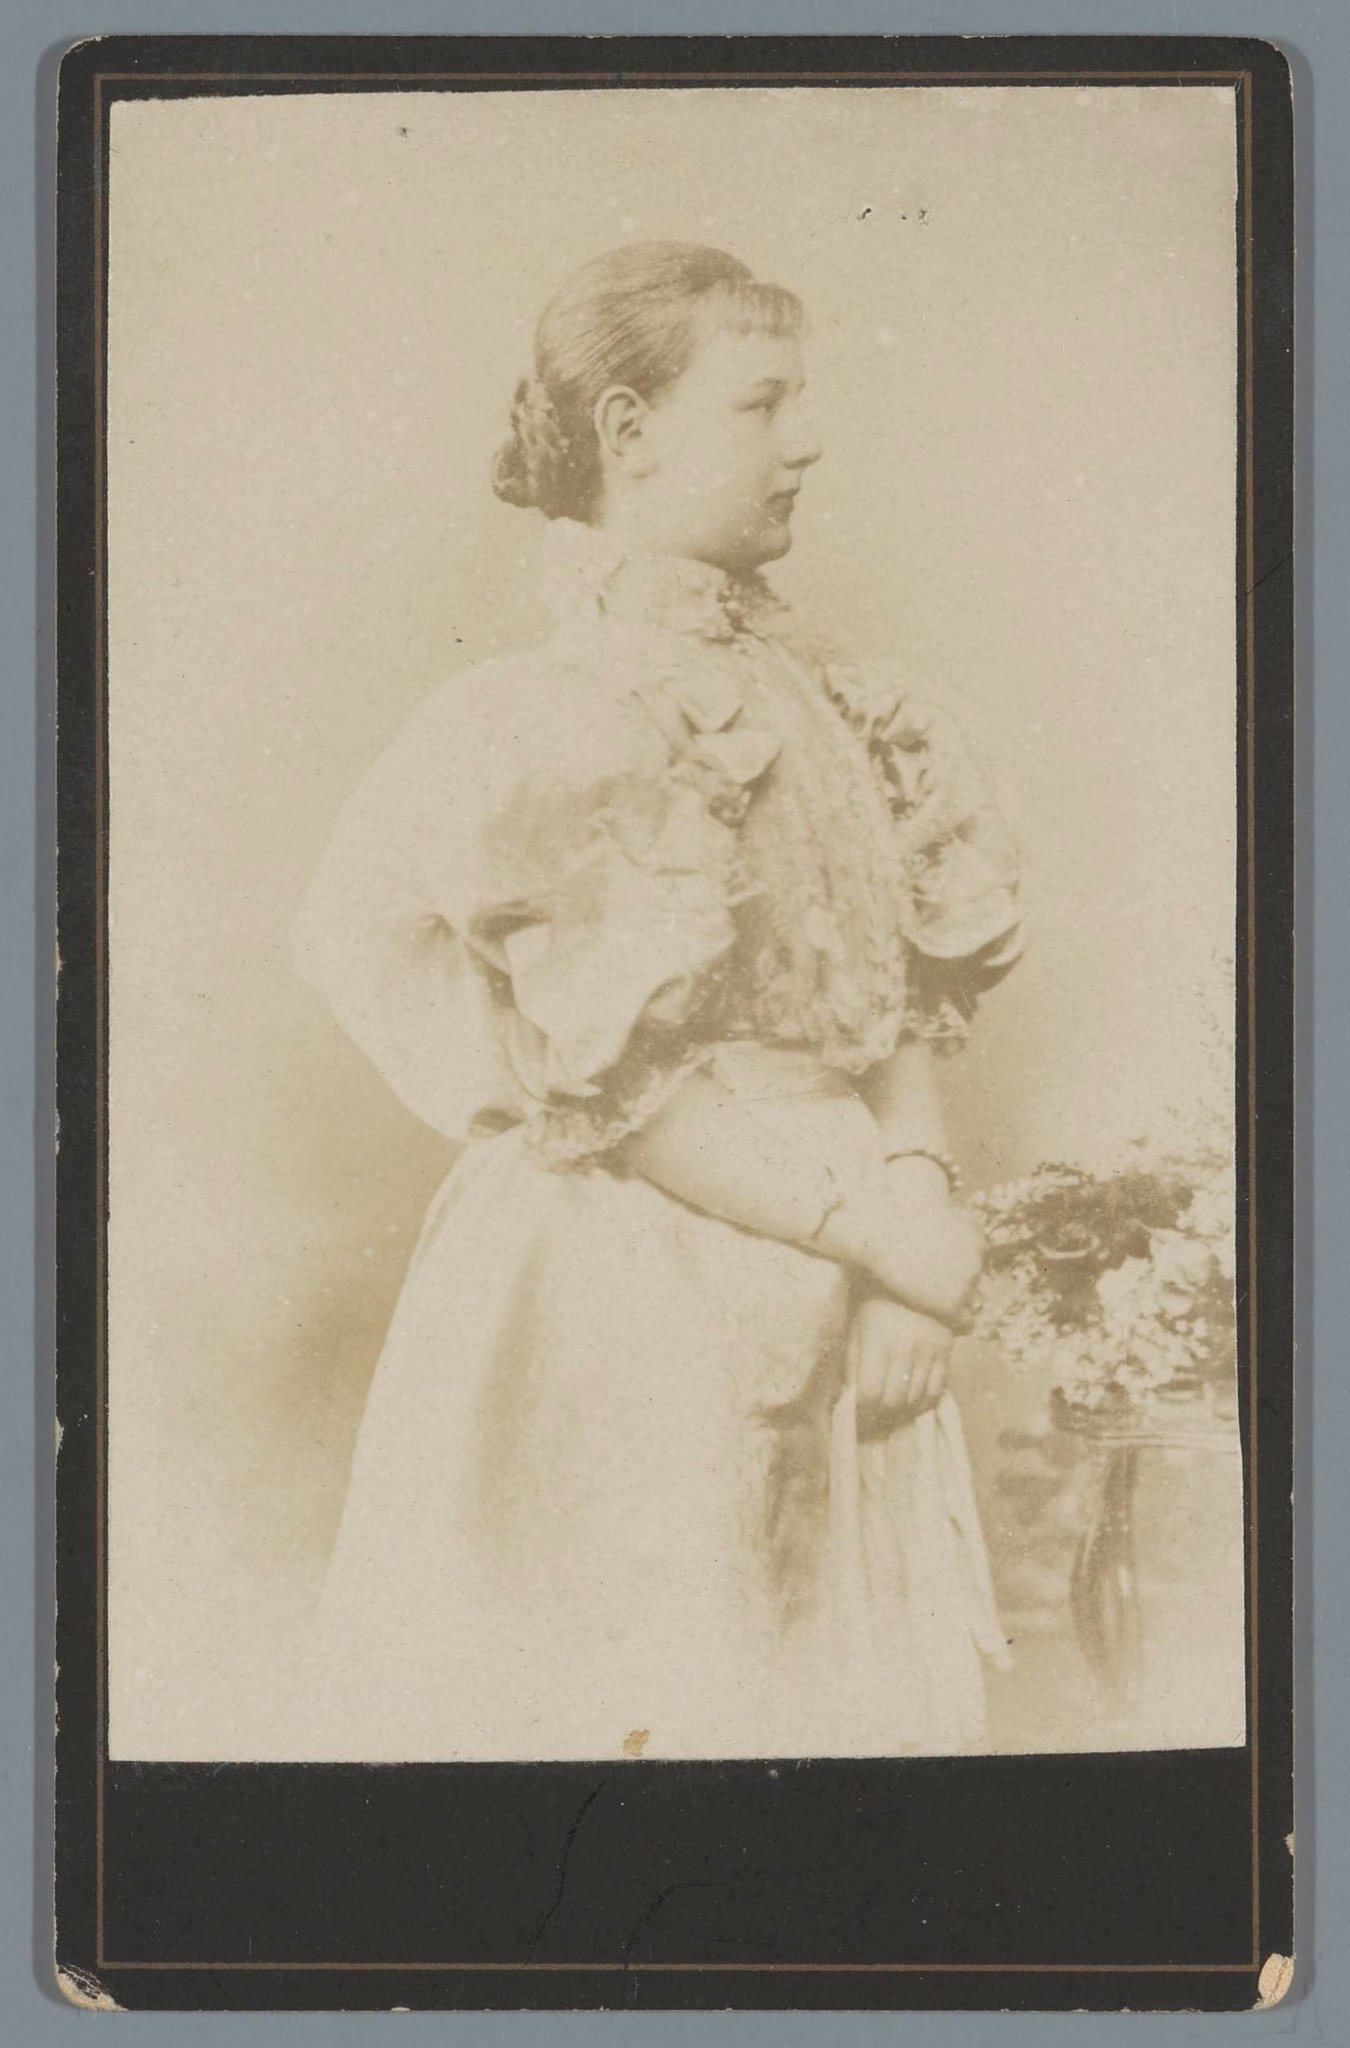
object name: carte de visite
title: Portret van prinses Wilhelmina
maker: kameke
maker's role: painter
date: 1895-1898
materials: cardboard, photographic support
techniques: collodion silver print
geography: the hague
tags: the hague, print maker, wilhelmina of the netherlands, crown princess, historical persons